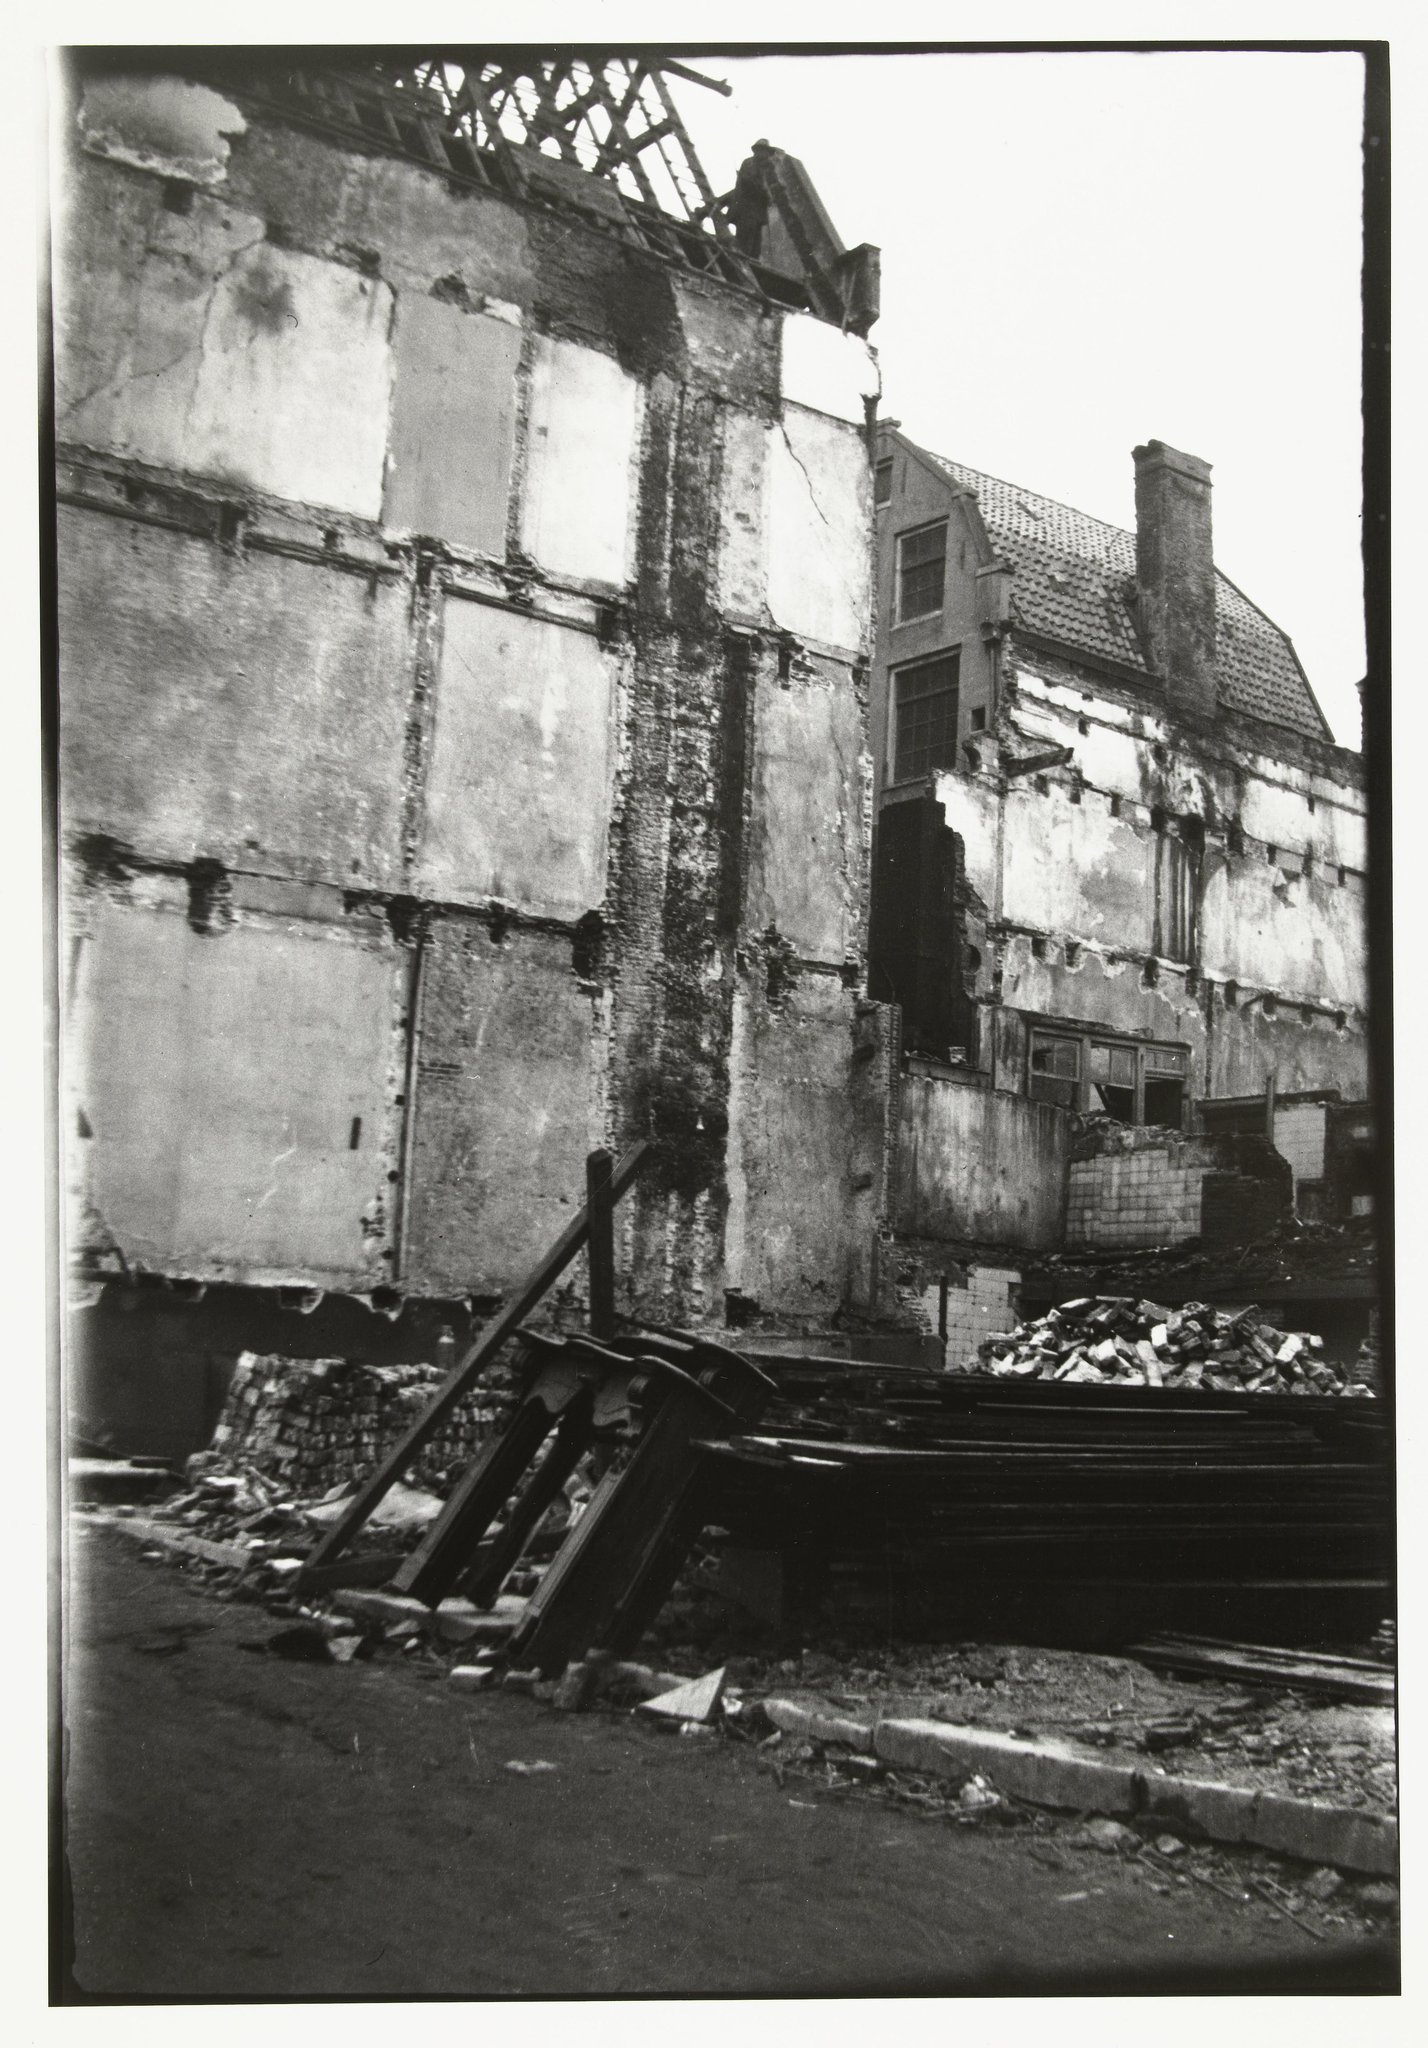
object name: photograph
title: Afbraak in een Amsterdamse straat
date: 1890-1910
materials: paper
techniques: gelatin silver print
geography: amsterdam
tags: amsterdam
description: Moderne afdruk van negatief BR 1065 (collectie RKD).